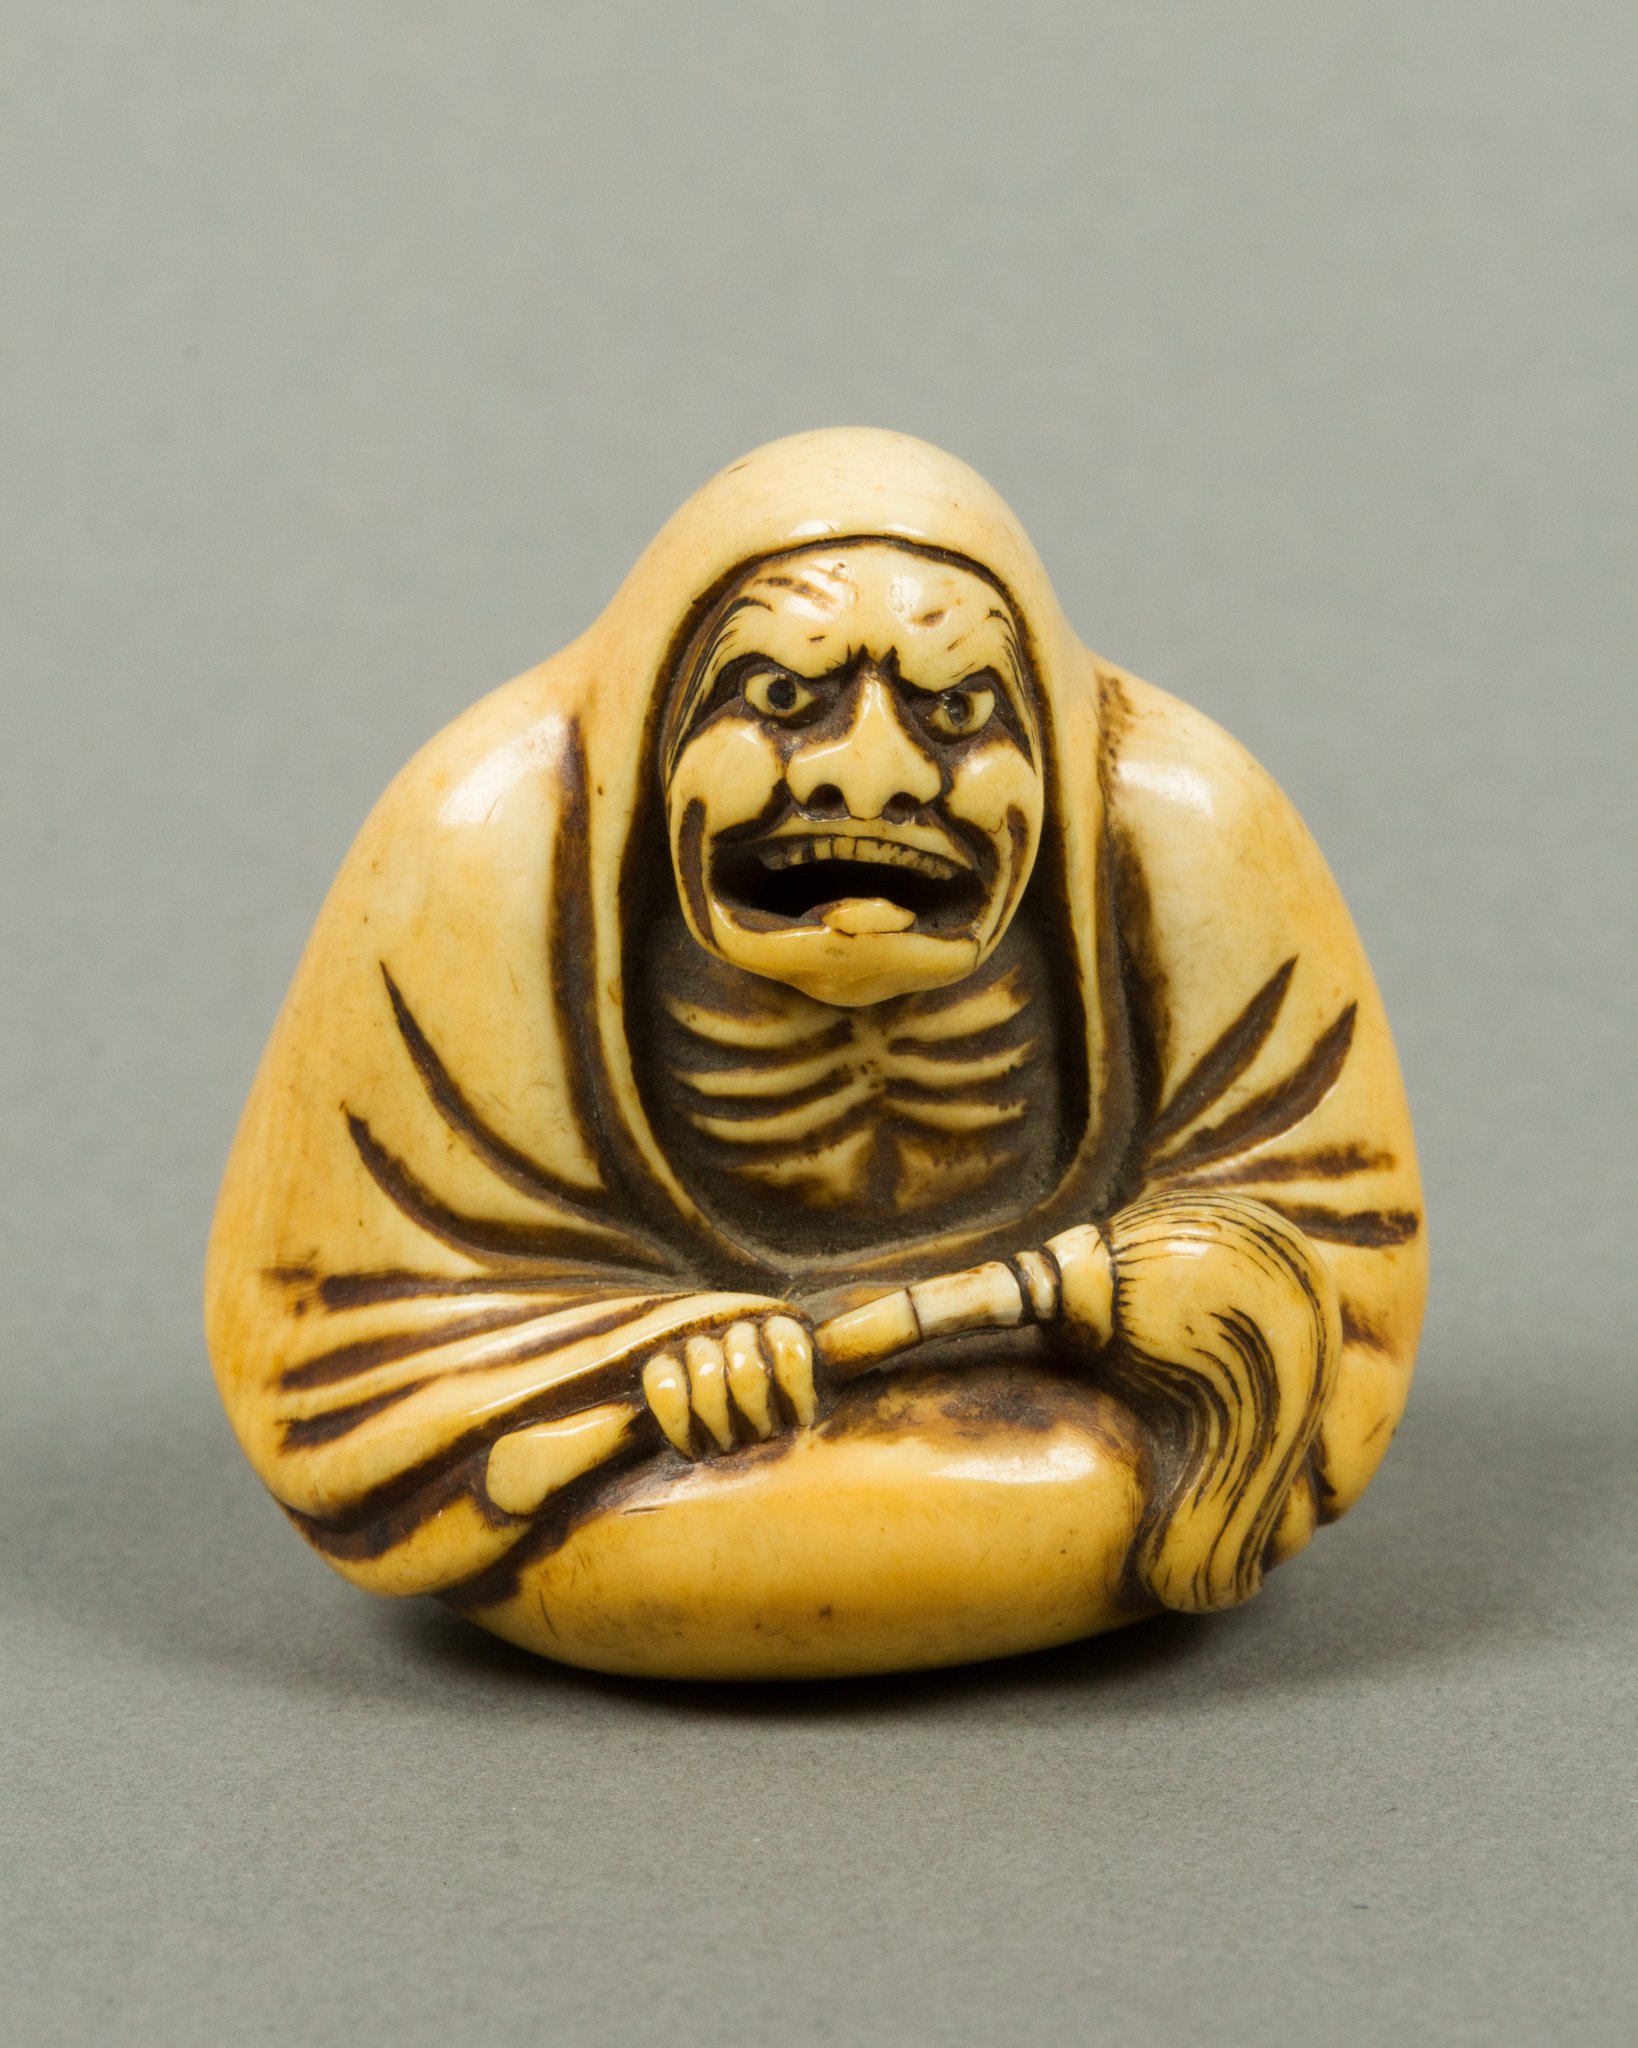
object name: netsuke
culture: japanese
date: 1801-1900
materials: ivory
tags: human figures